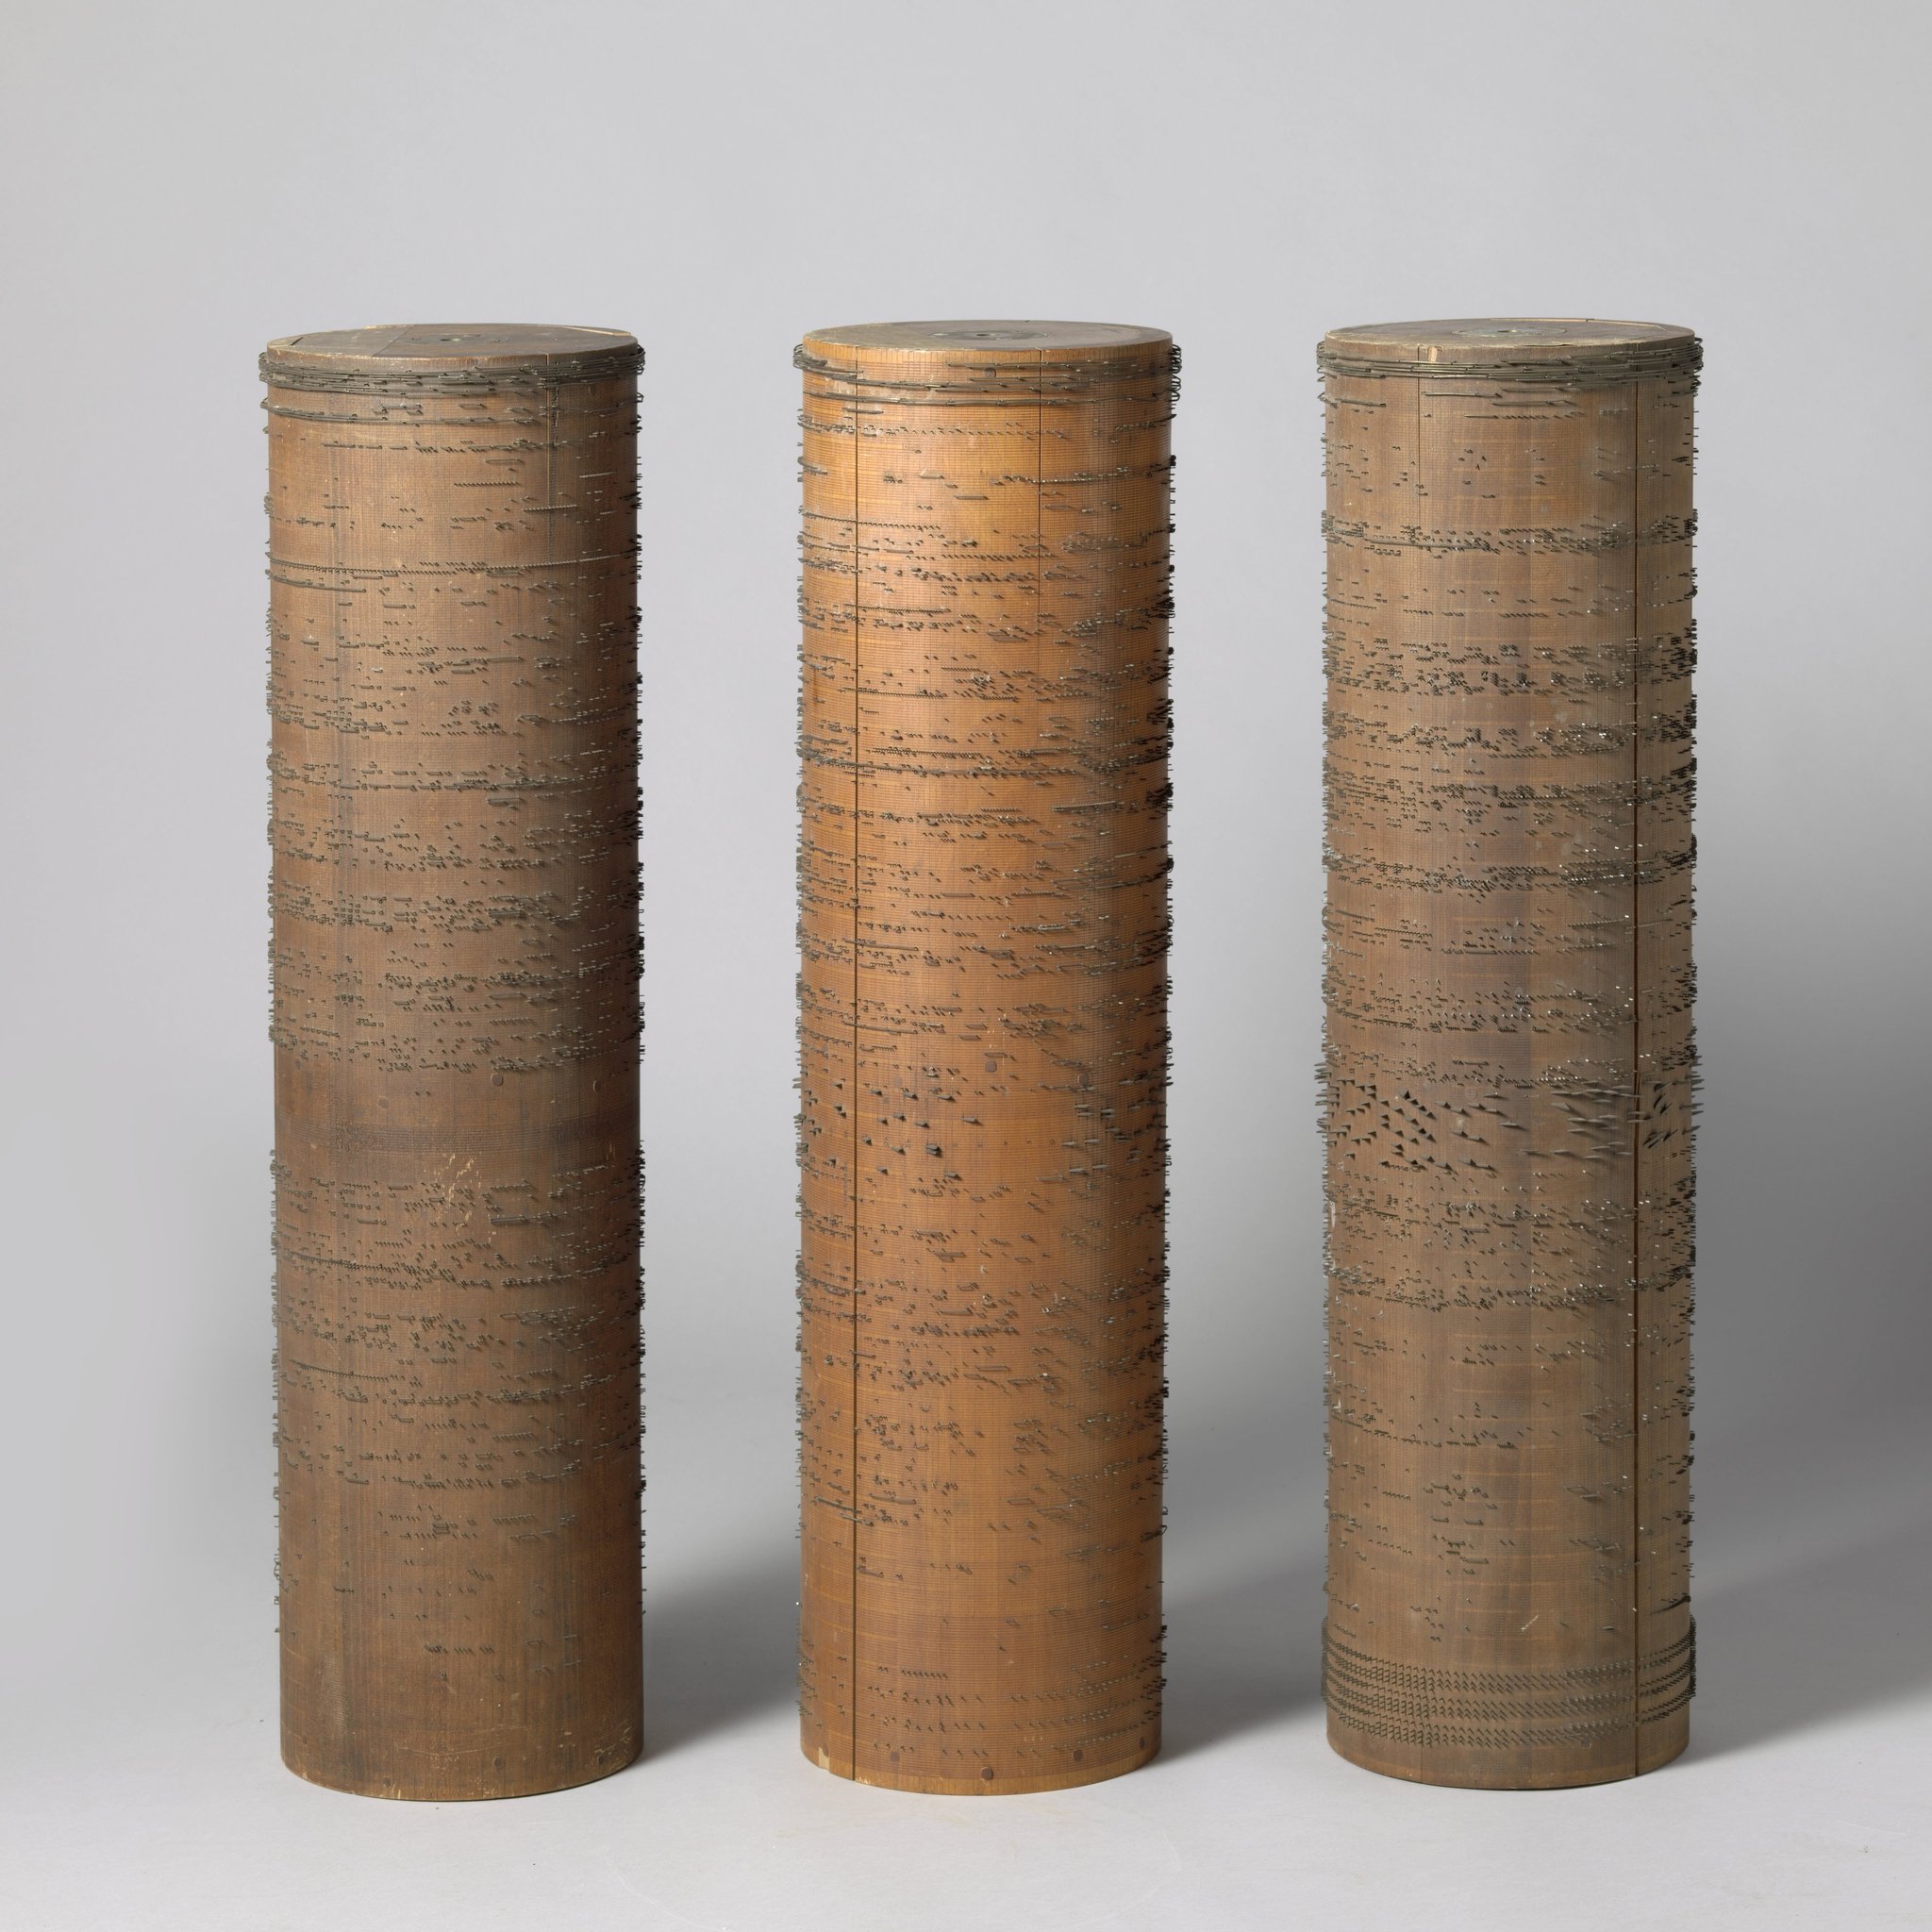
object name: musical instrument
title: Barrel for a mechanical organ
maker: harmanus dolman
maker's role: musical instrument maker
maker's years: 1787-1852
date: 1815-1825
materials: metal, wood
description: Cilinder voor een mechanisch orgel. 10 segmenten, 4 schroeven in messing plaat.